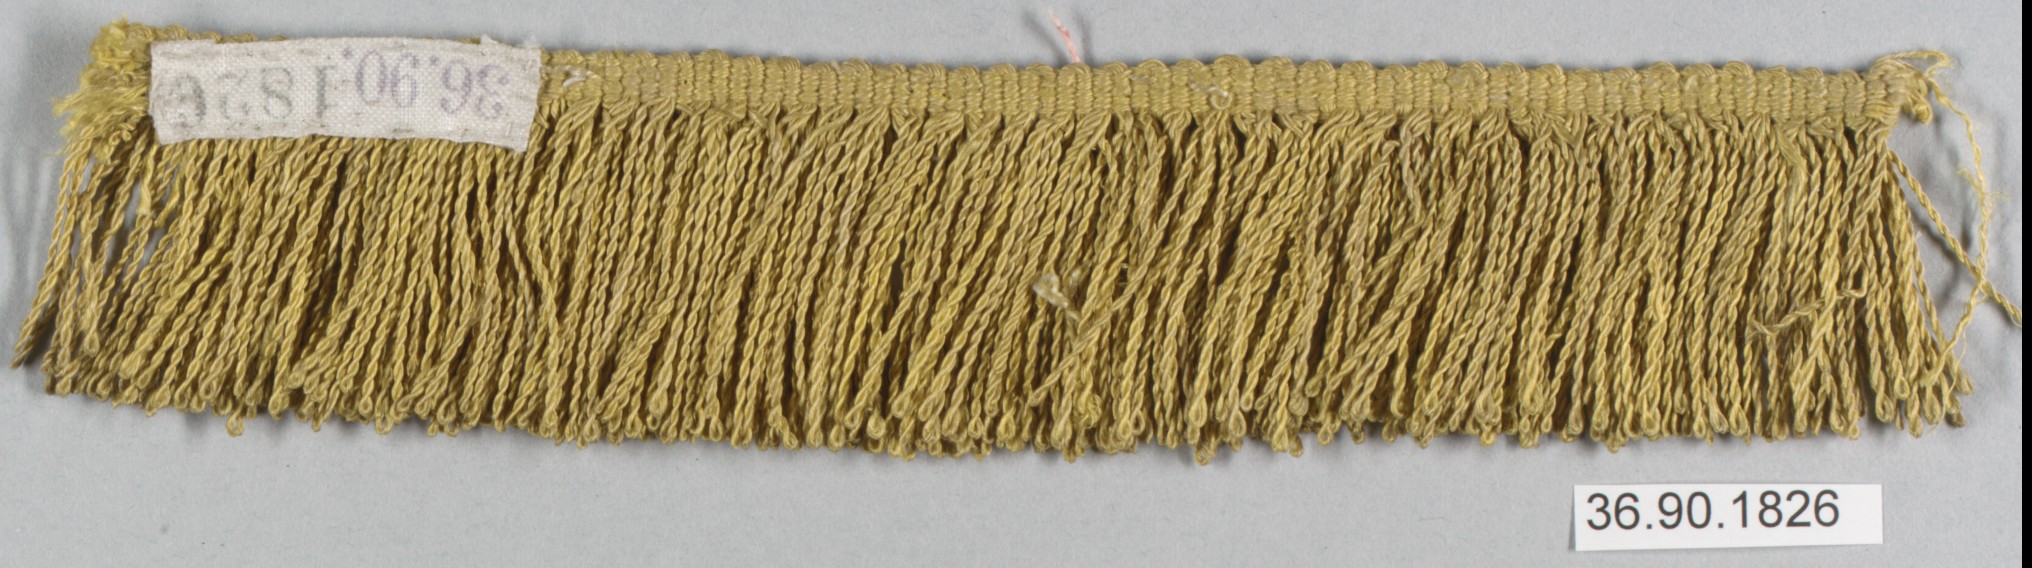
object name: fringe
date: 1667-1700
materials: silk